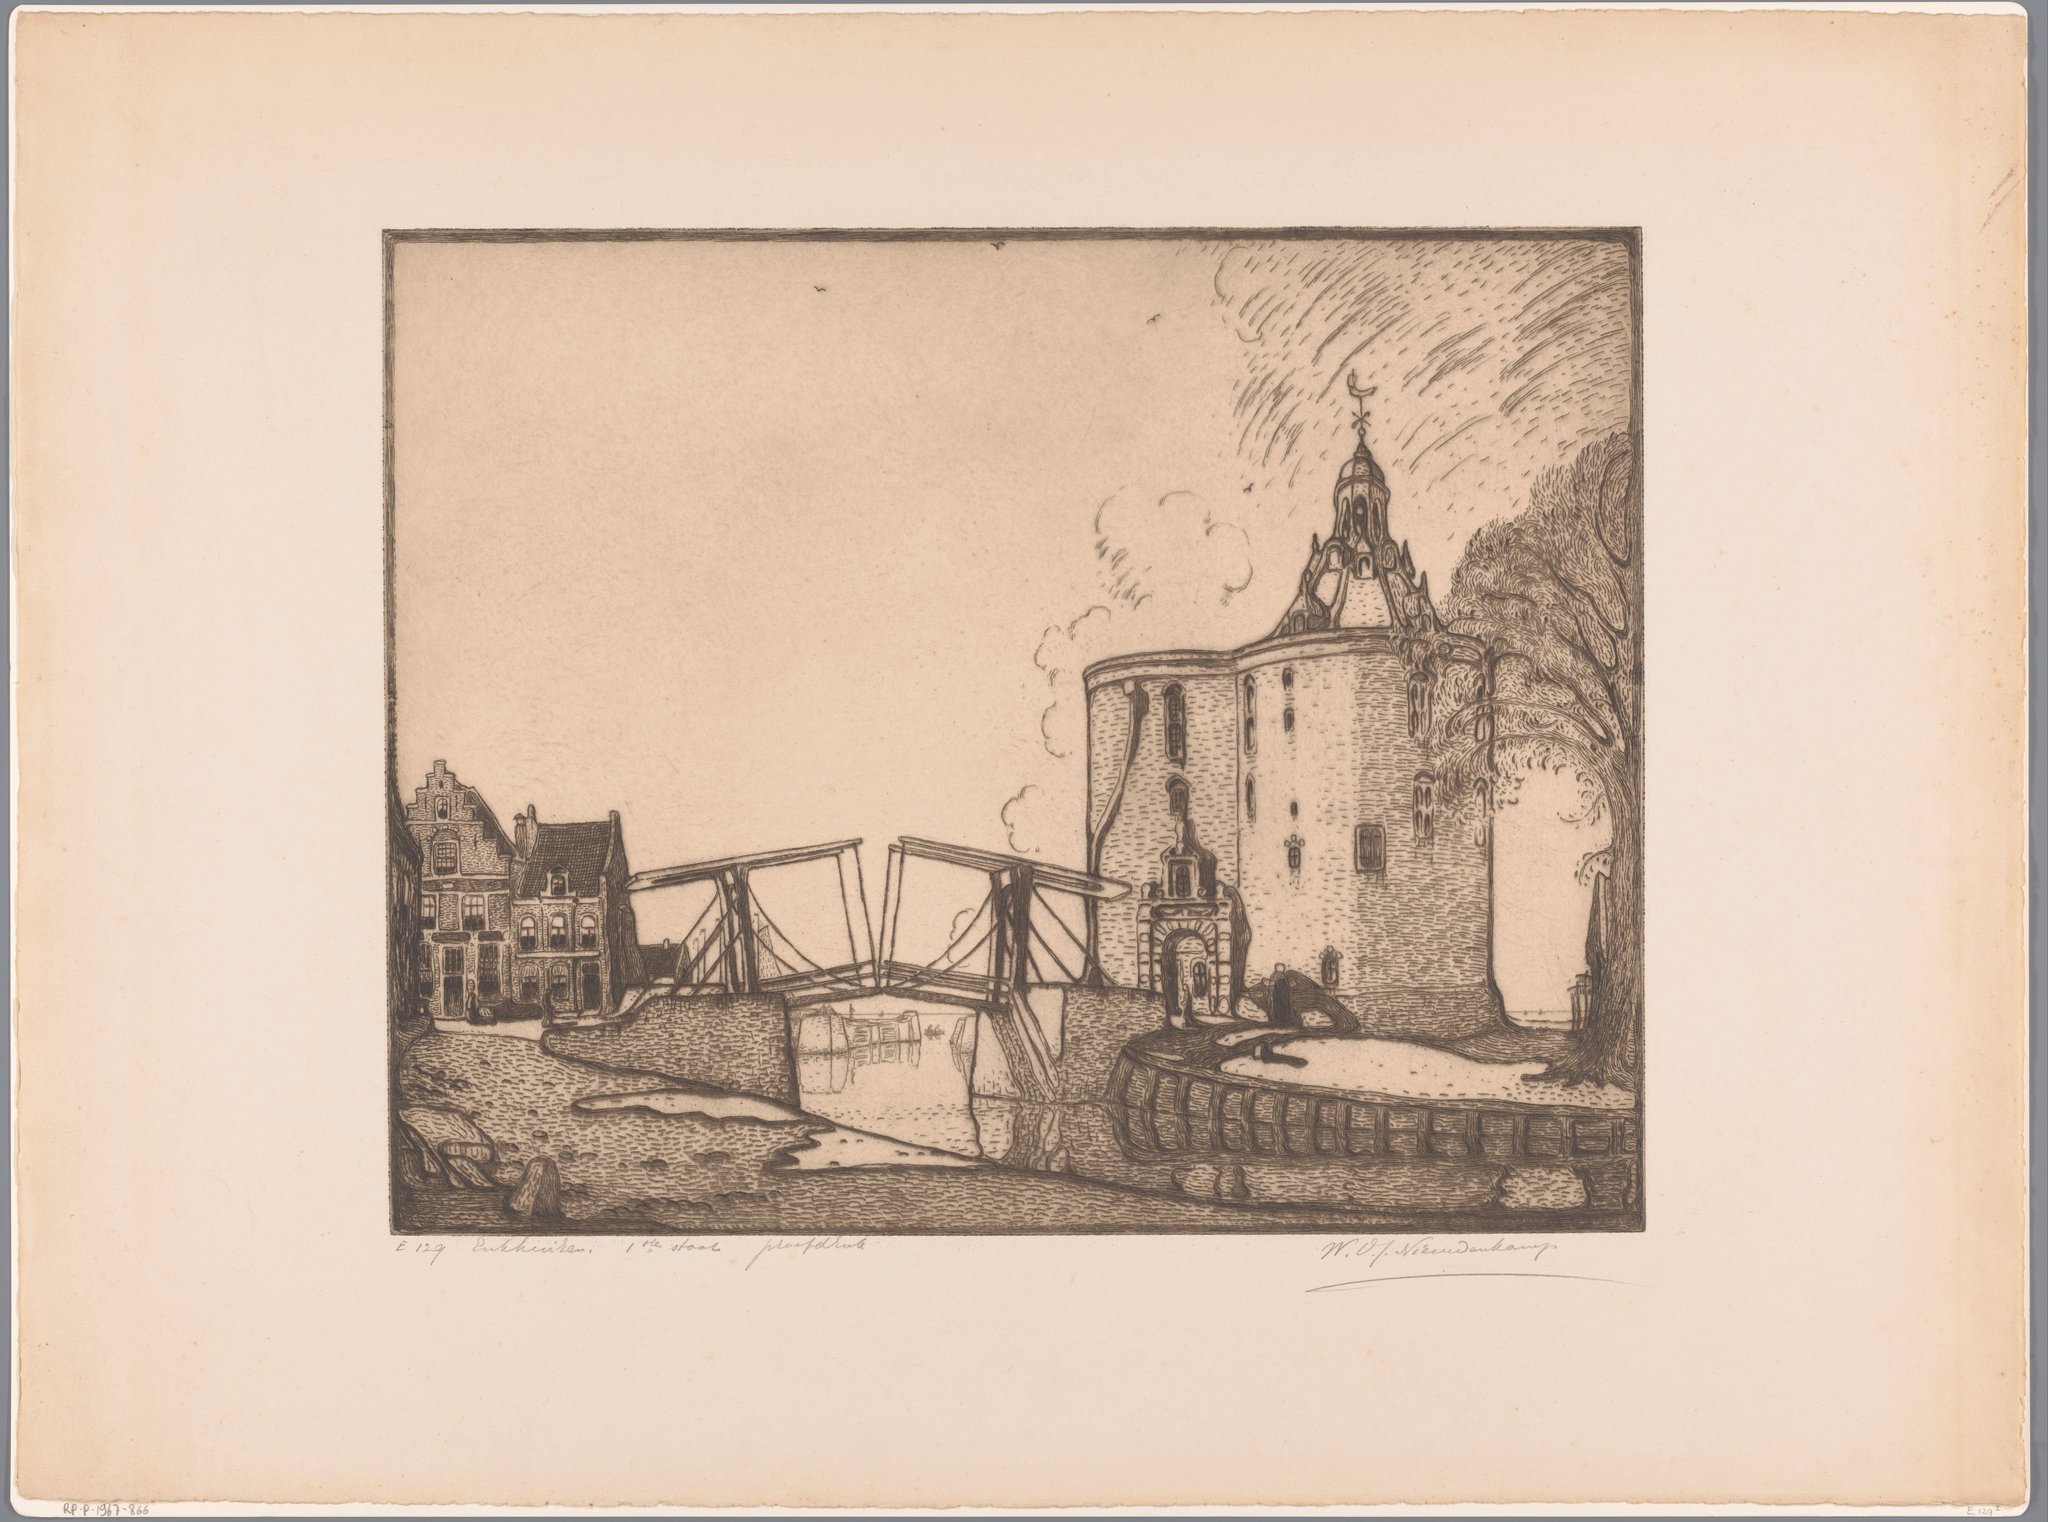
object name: print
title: Enkhuizen, de Dromedaris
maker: wijnand otto jan nieuwenkamp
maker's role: draughtsman, print maker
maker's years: 1874-1950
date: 1912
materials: paper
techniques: etching, intaglio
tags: canals, waters (in city), bridge, city-gate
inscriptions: collector's mark: Lugt 2760, collector's mark: Lugt 2228